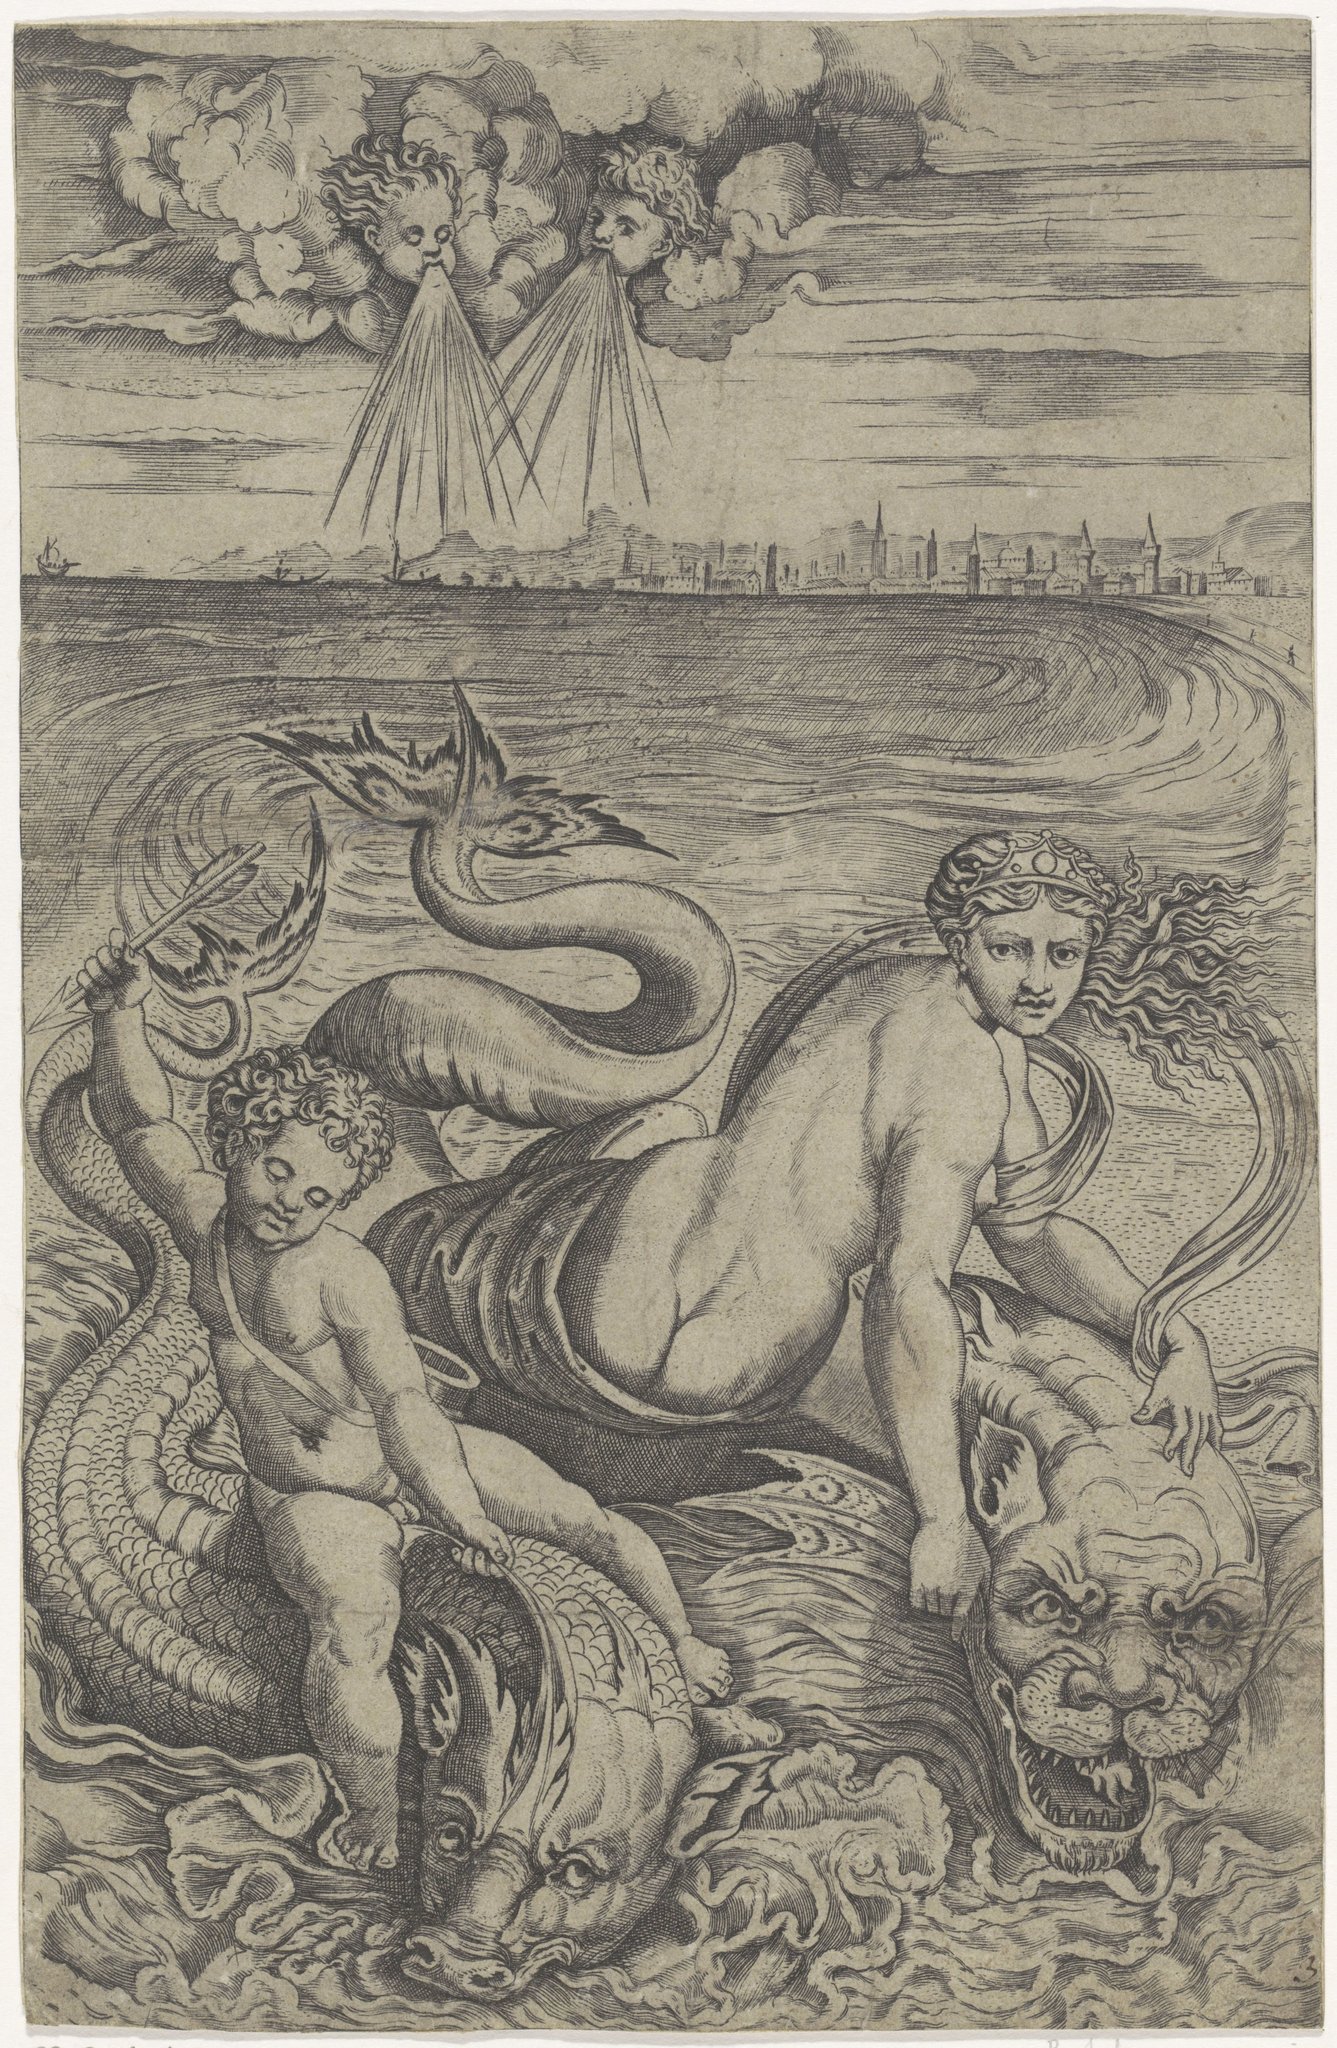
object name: print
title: Venus en Amor gedragen door dolfijnen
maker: Anonymous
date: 1510-1577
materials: paper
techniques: engraving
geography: italy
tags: venus, standing on a shell, sails with her veil over the water (alternatively she is riding on a dolphin): venus marina, venus and cupid (cupid not being mere attribute)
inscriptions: collector's mark: Lugt 10, number: ‘3’, collector's mark: Lugt 11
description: Venus en Amor zitten ieder op een dolfijn of zeemonster. Op de achtergrond een kust met een stad. Aan de hemel de blazende winden.